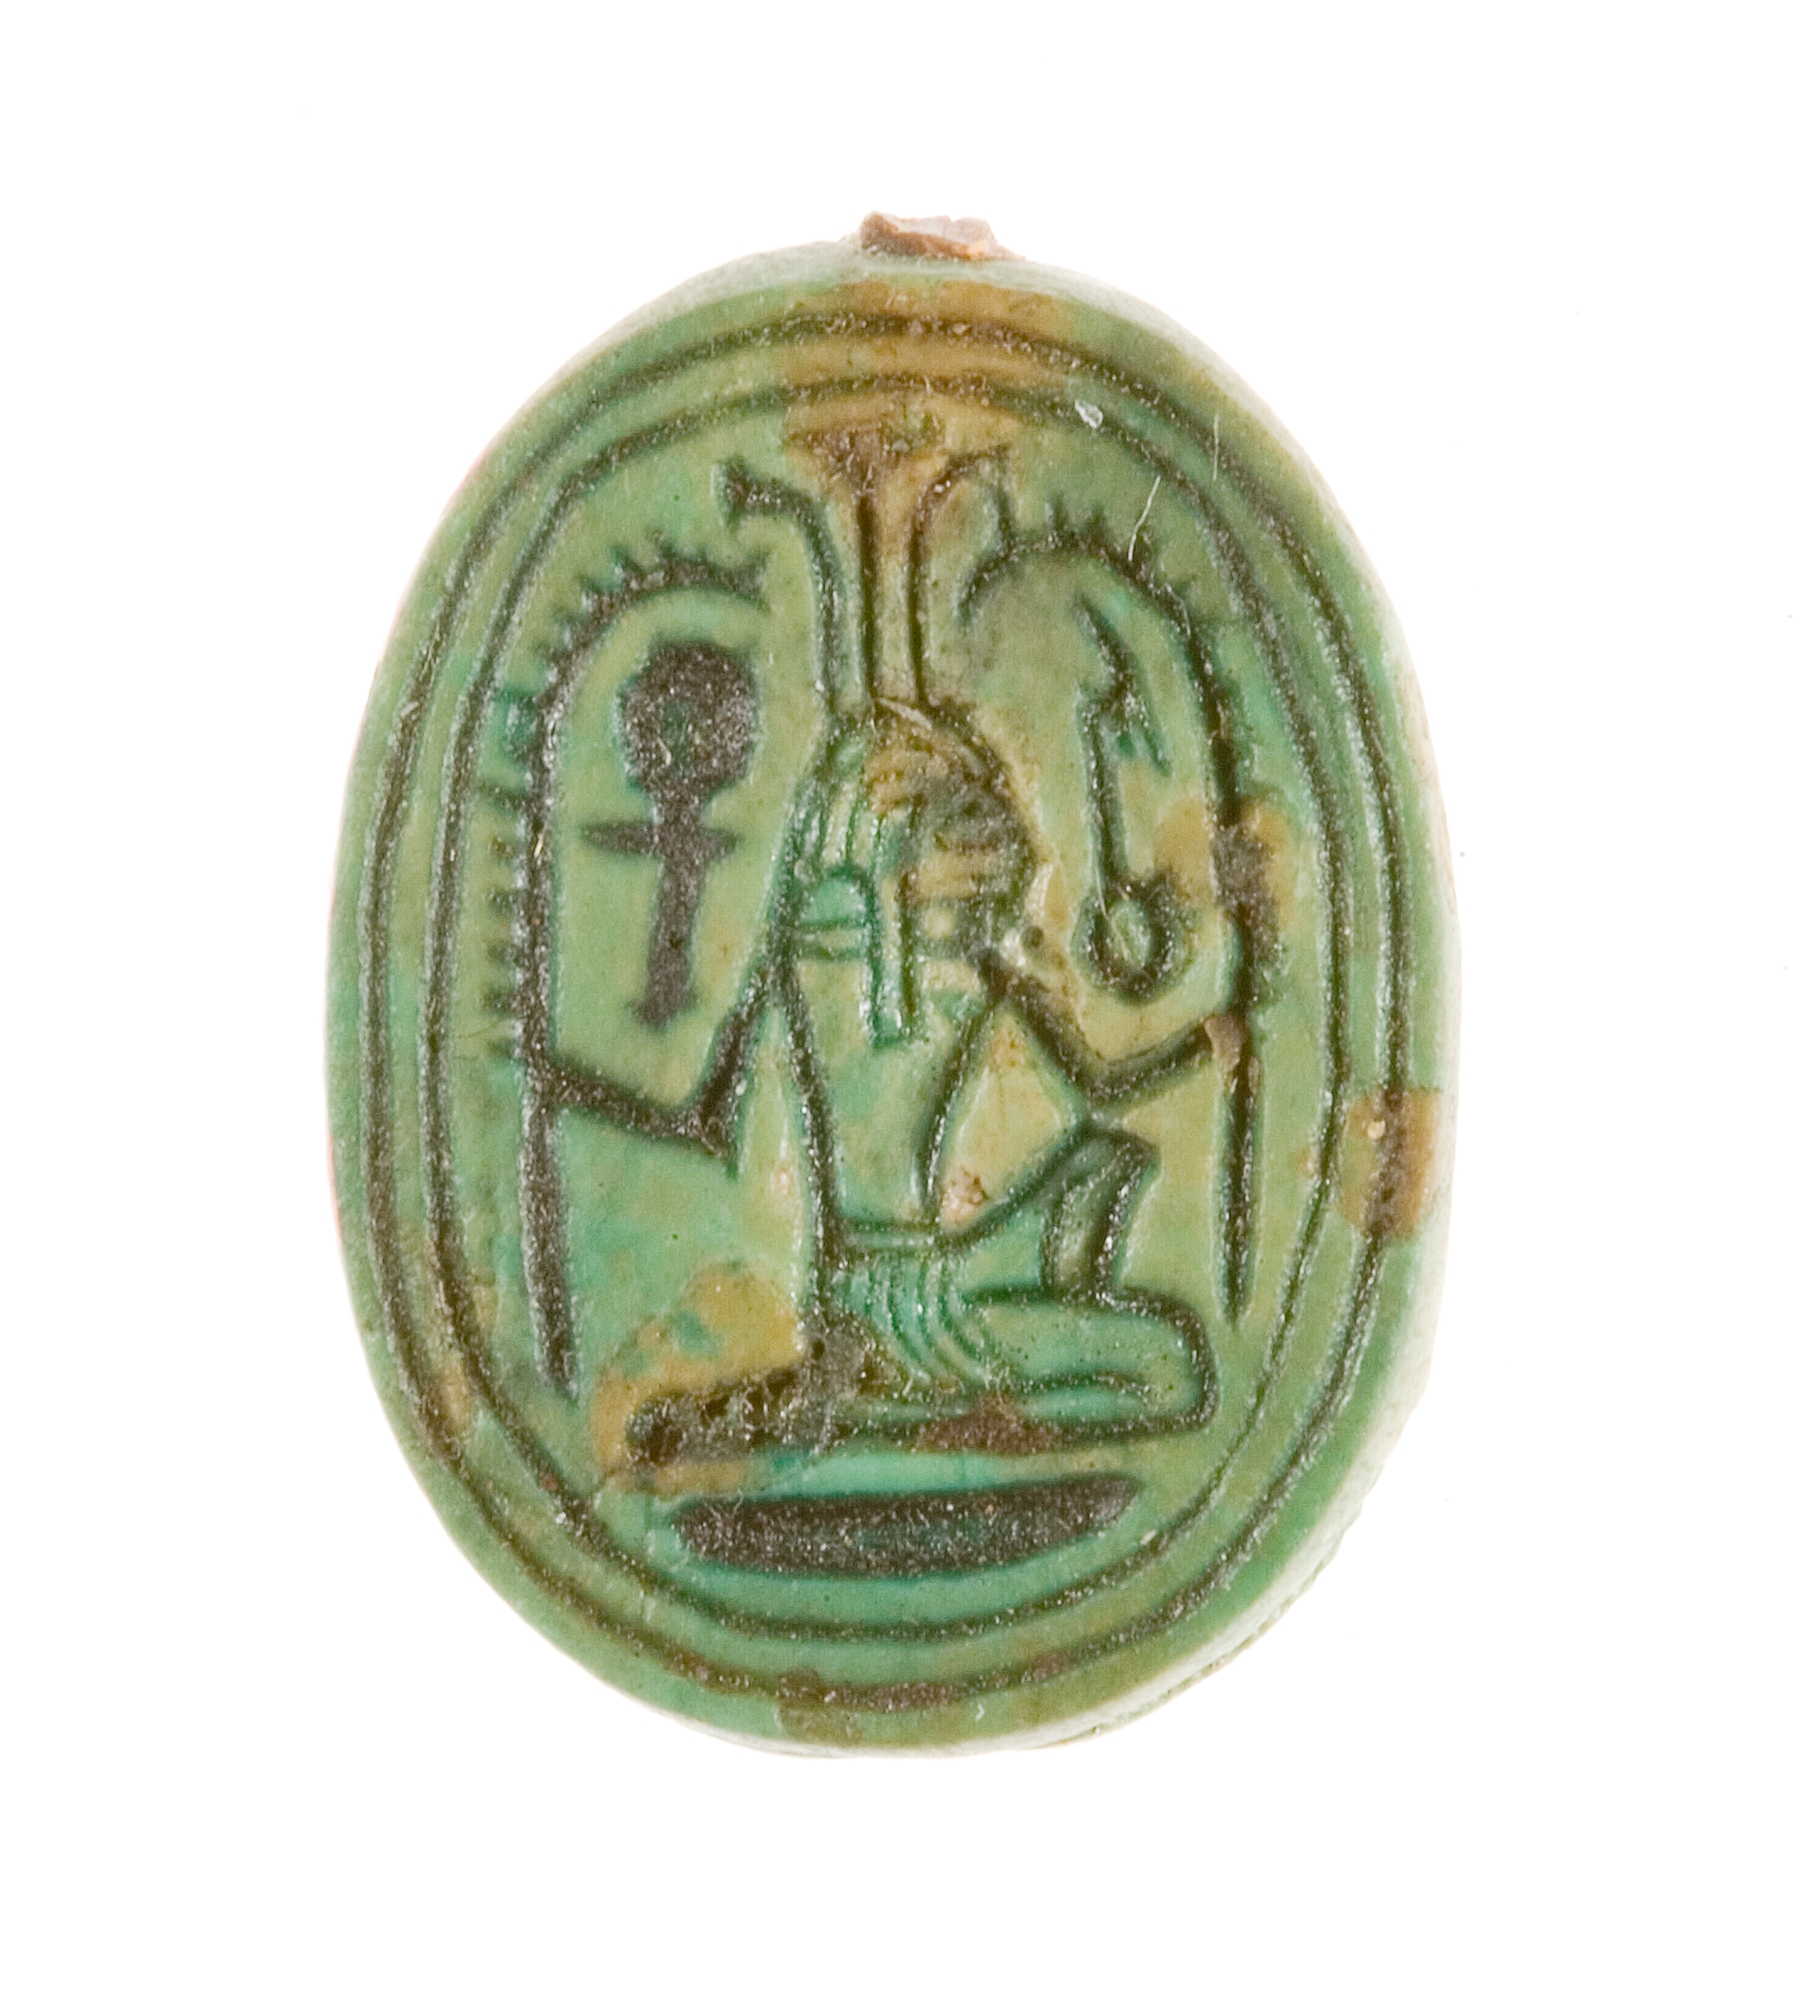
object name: scarab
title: Scarab Inscribed with a Hieroglyphic Motif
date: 1479-1458 BCE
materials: stone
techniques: glazing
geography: egypt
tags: hieroglyphs,scarabs